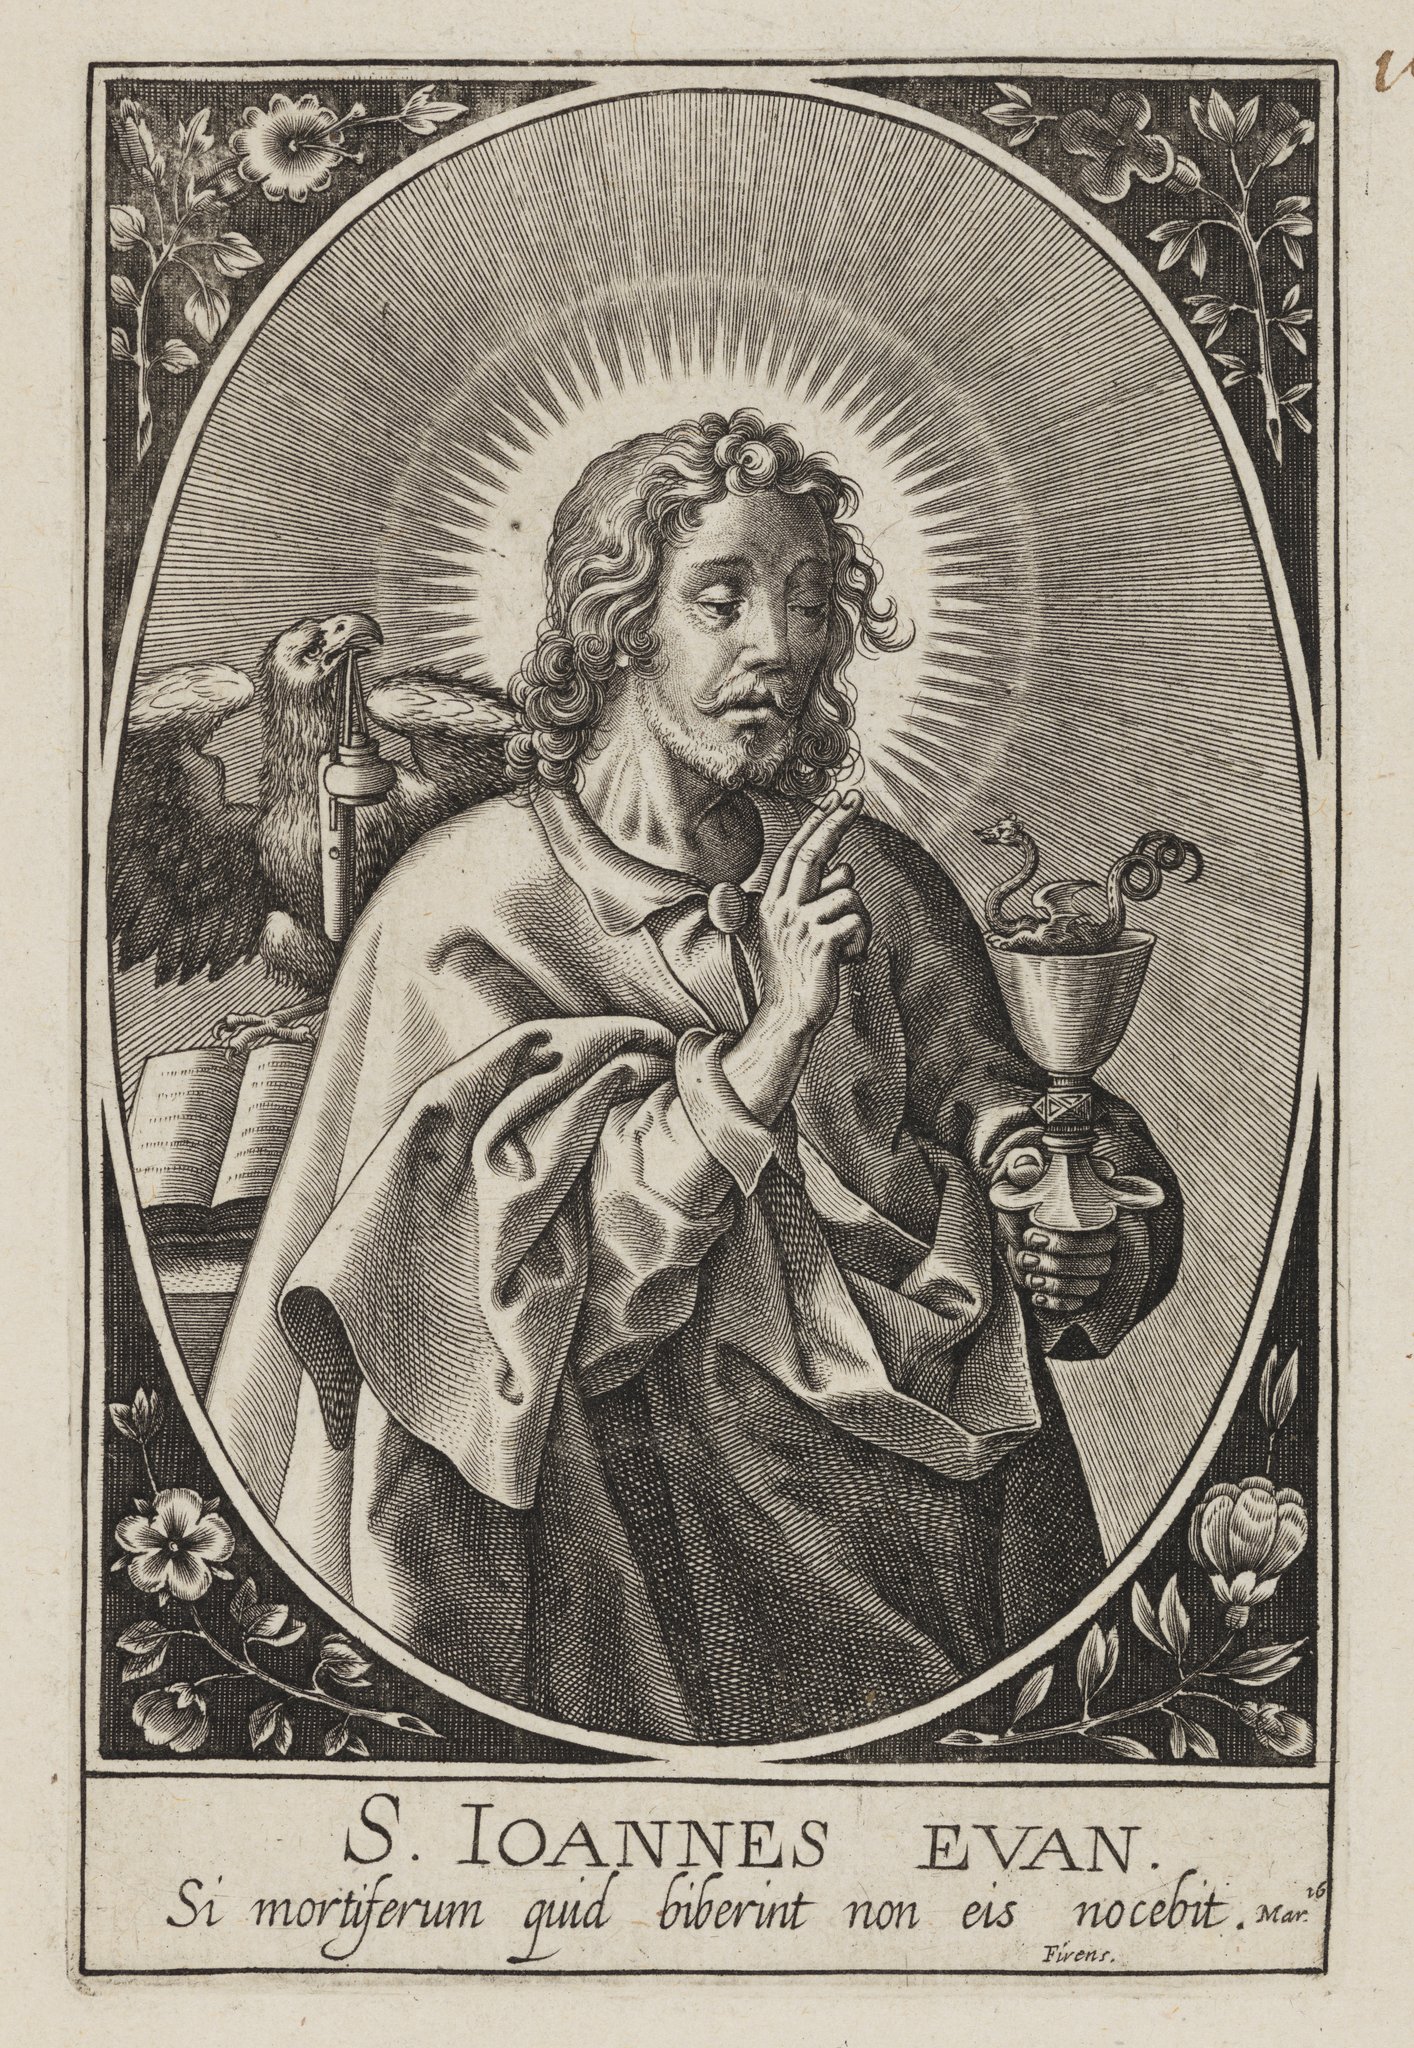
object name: print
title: St. John the Evangelist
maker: anonymous, french, 17th century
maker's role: artist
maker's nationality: french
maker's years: 1600-1700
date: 1576-1641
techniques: engraving